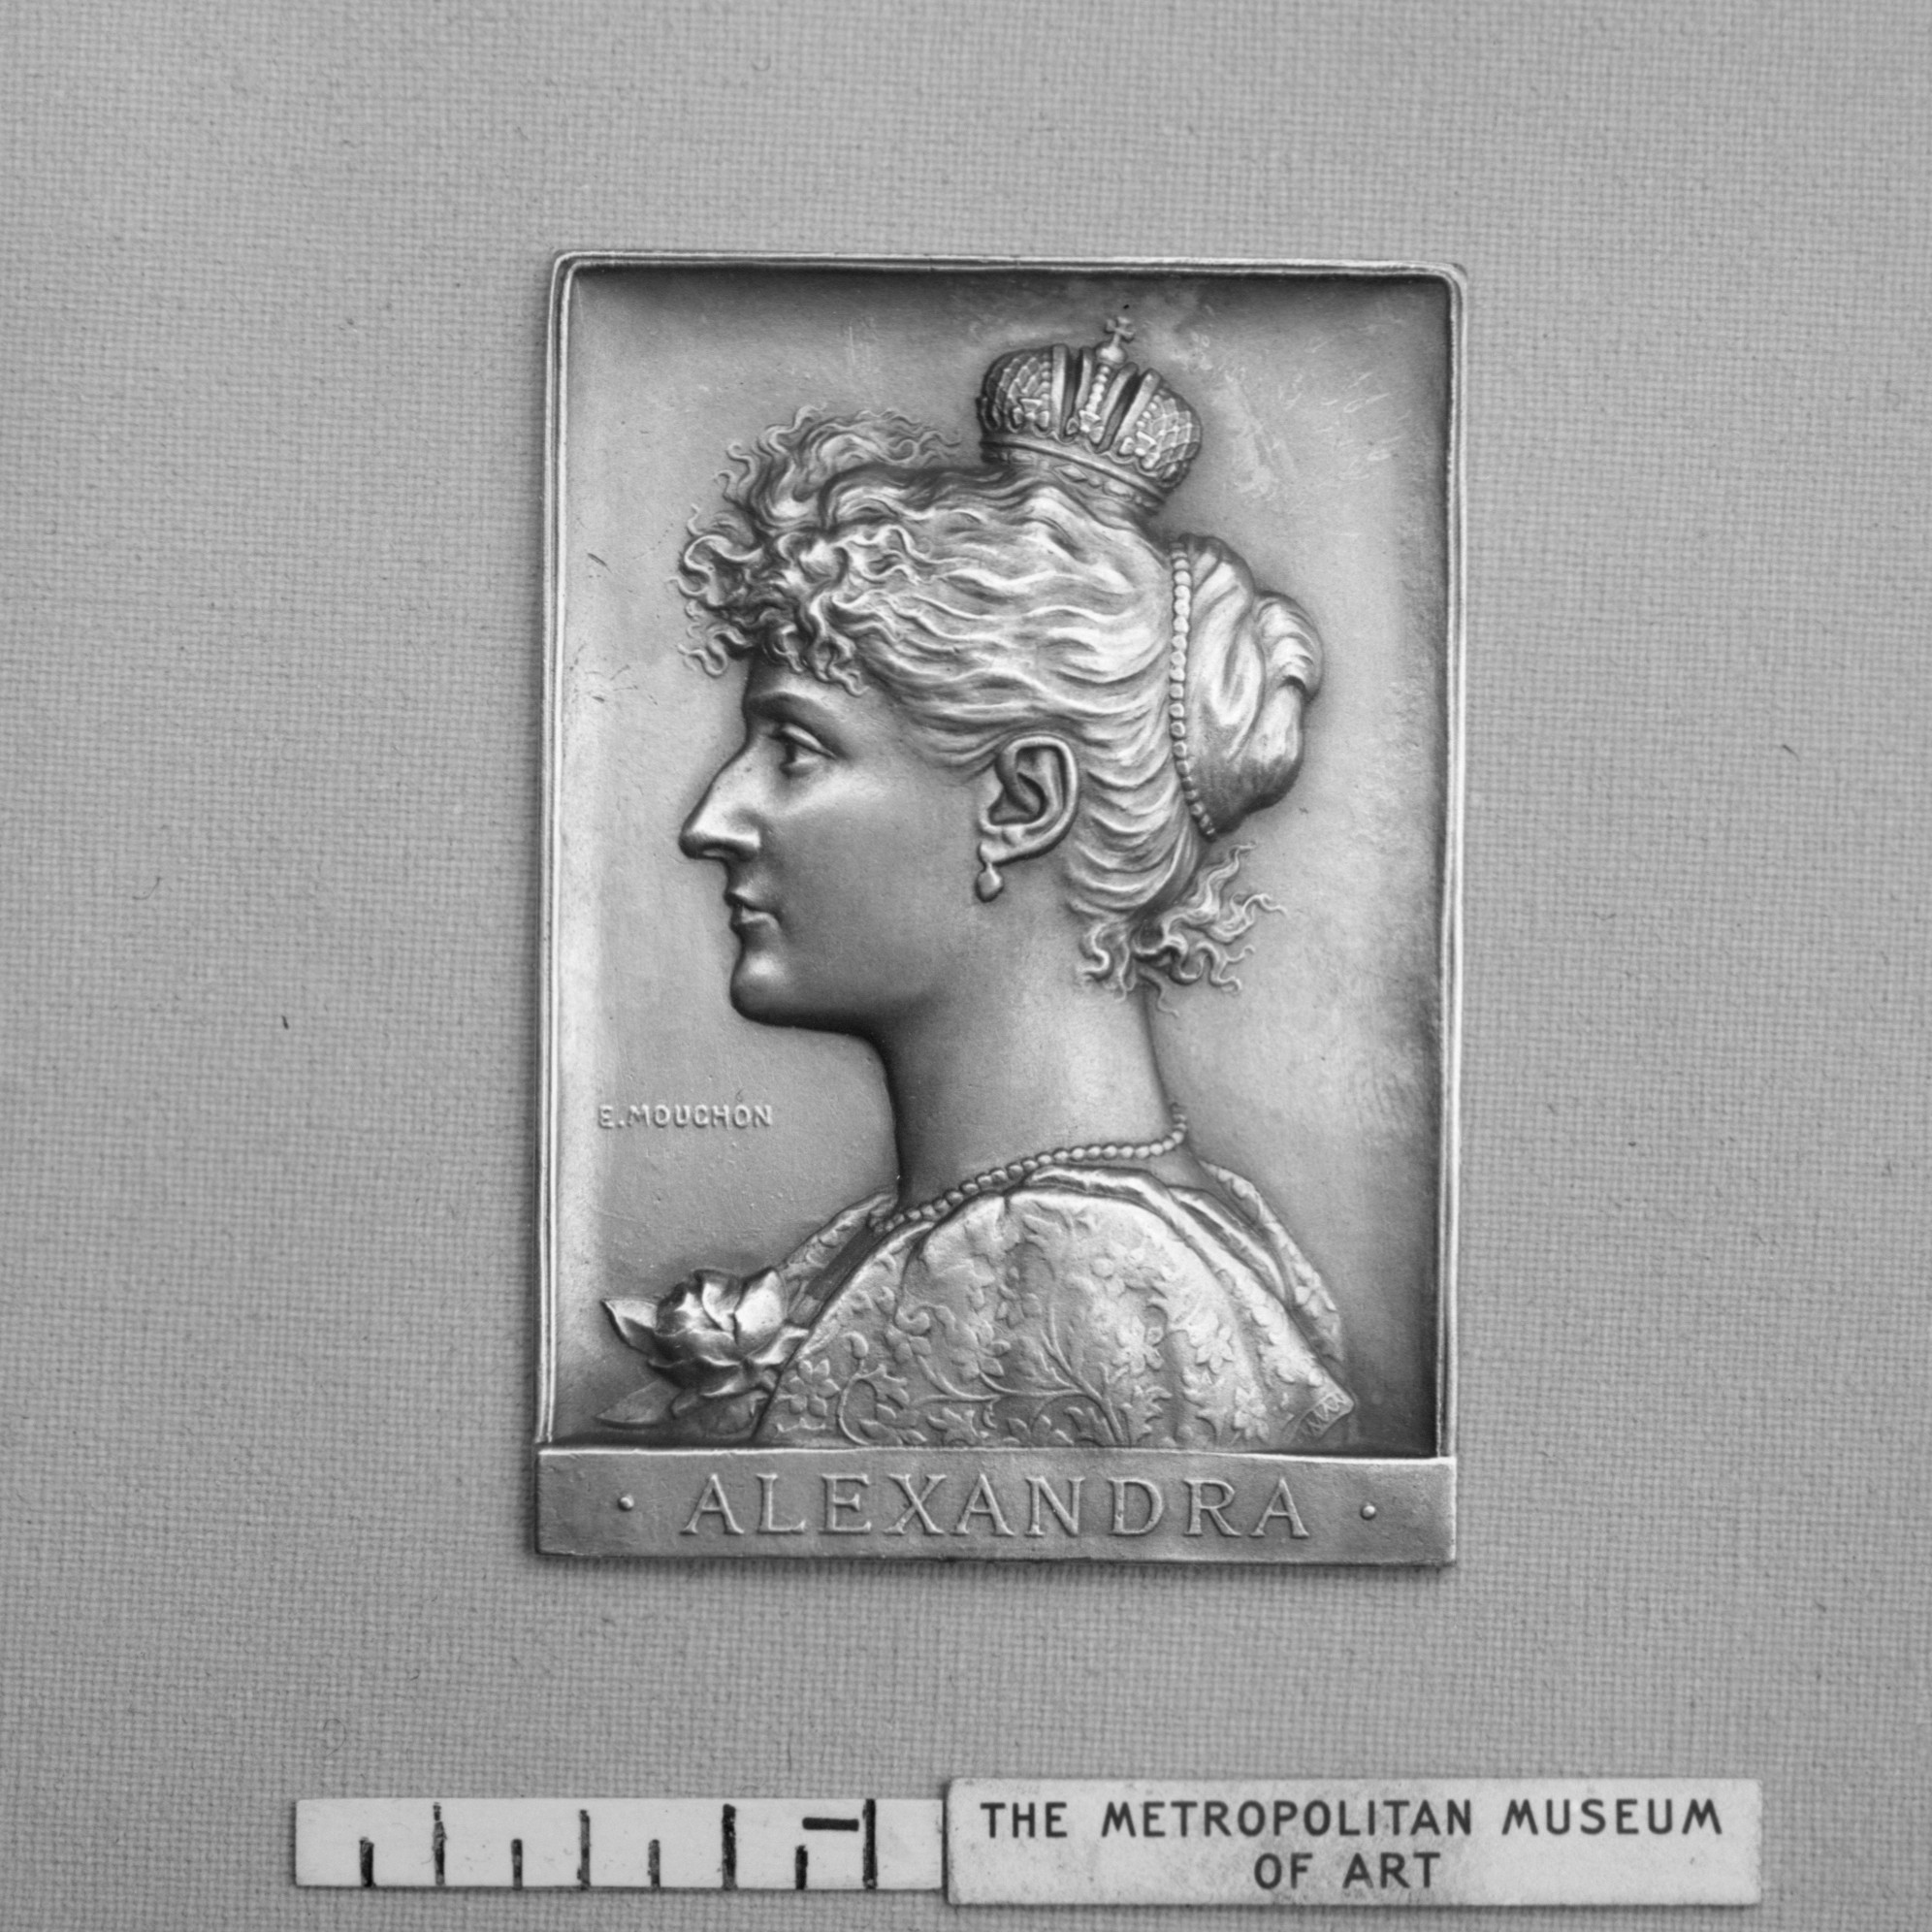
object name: plaquette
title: To Commemorate the Visit of the Tsar Nicholas II and the Tsarista to Paris in 1902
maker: louis eugène mouchon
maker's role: artist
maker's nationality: french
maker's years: 1843-1914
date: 1902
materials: bronze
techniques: silvered, struck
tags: profiles,women